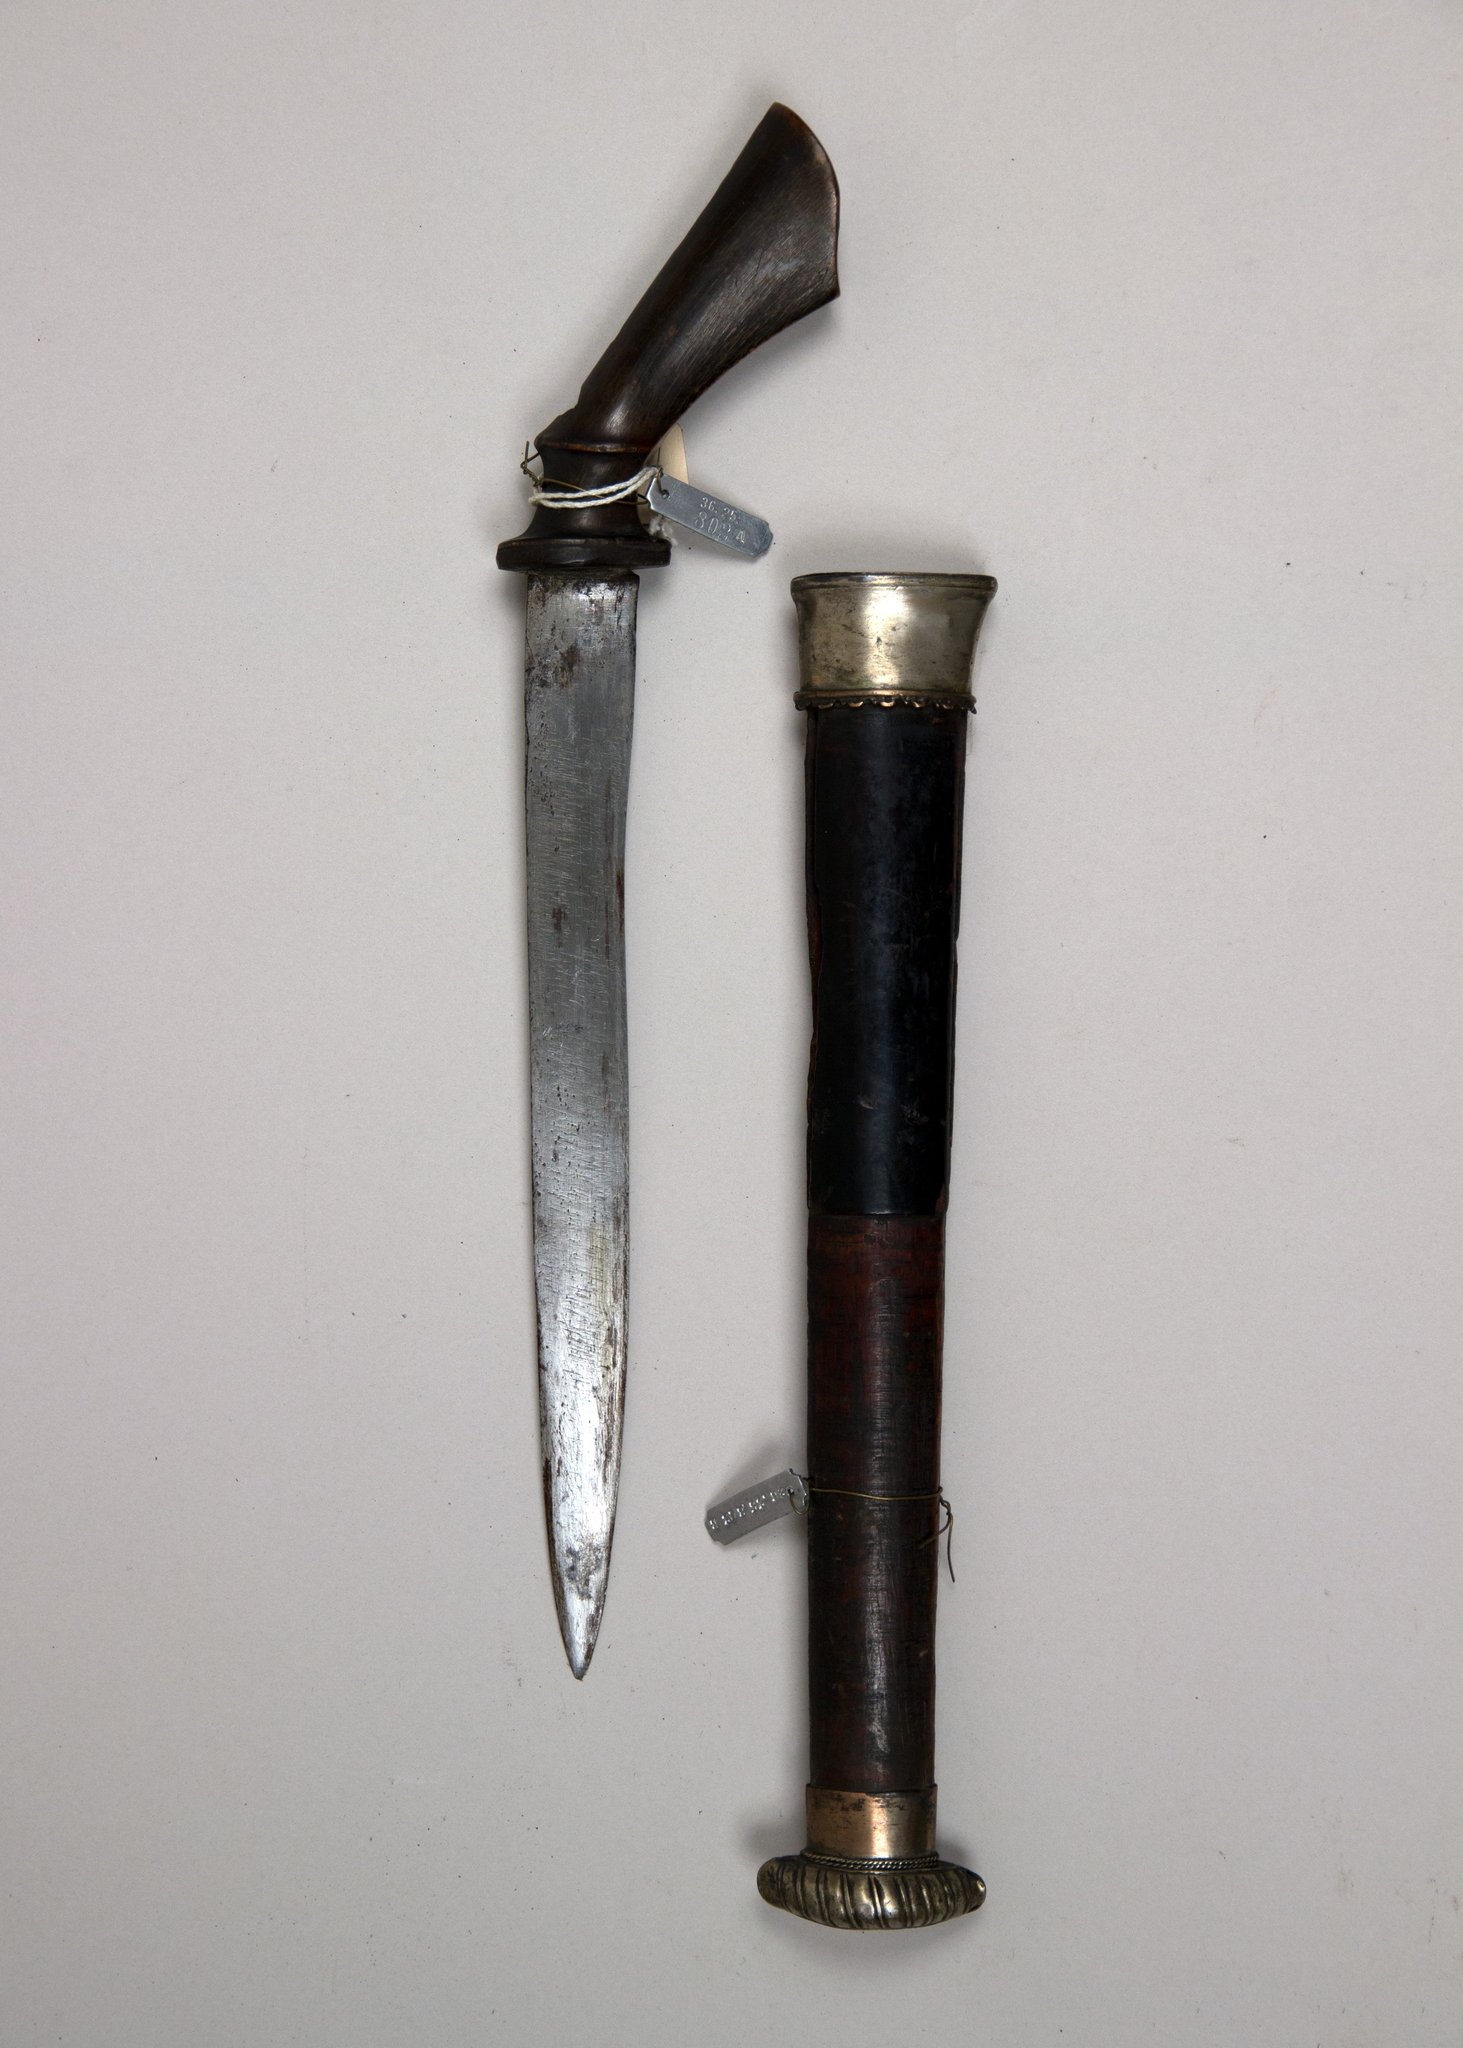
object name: knife with sheath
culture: malayan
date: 1701-1900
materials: horn, silver, steel, wood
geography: malaysia